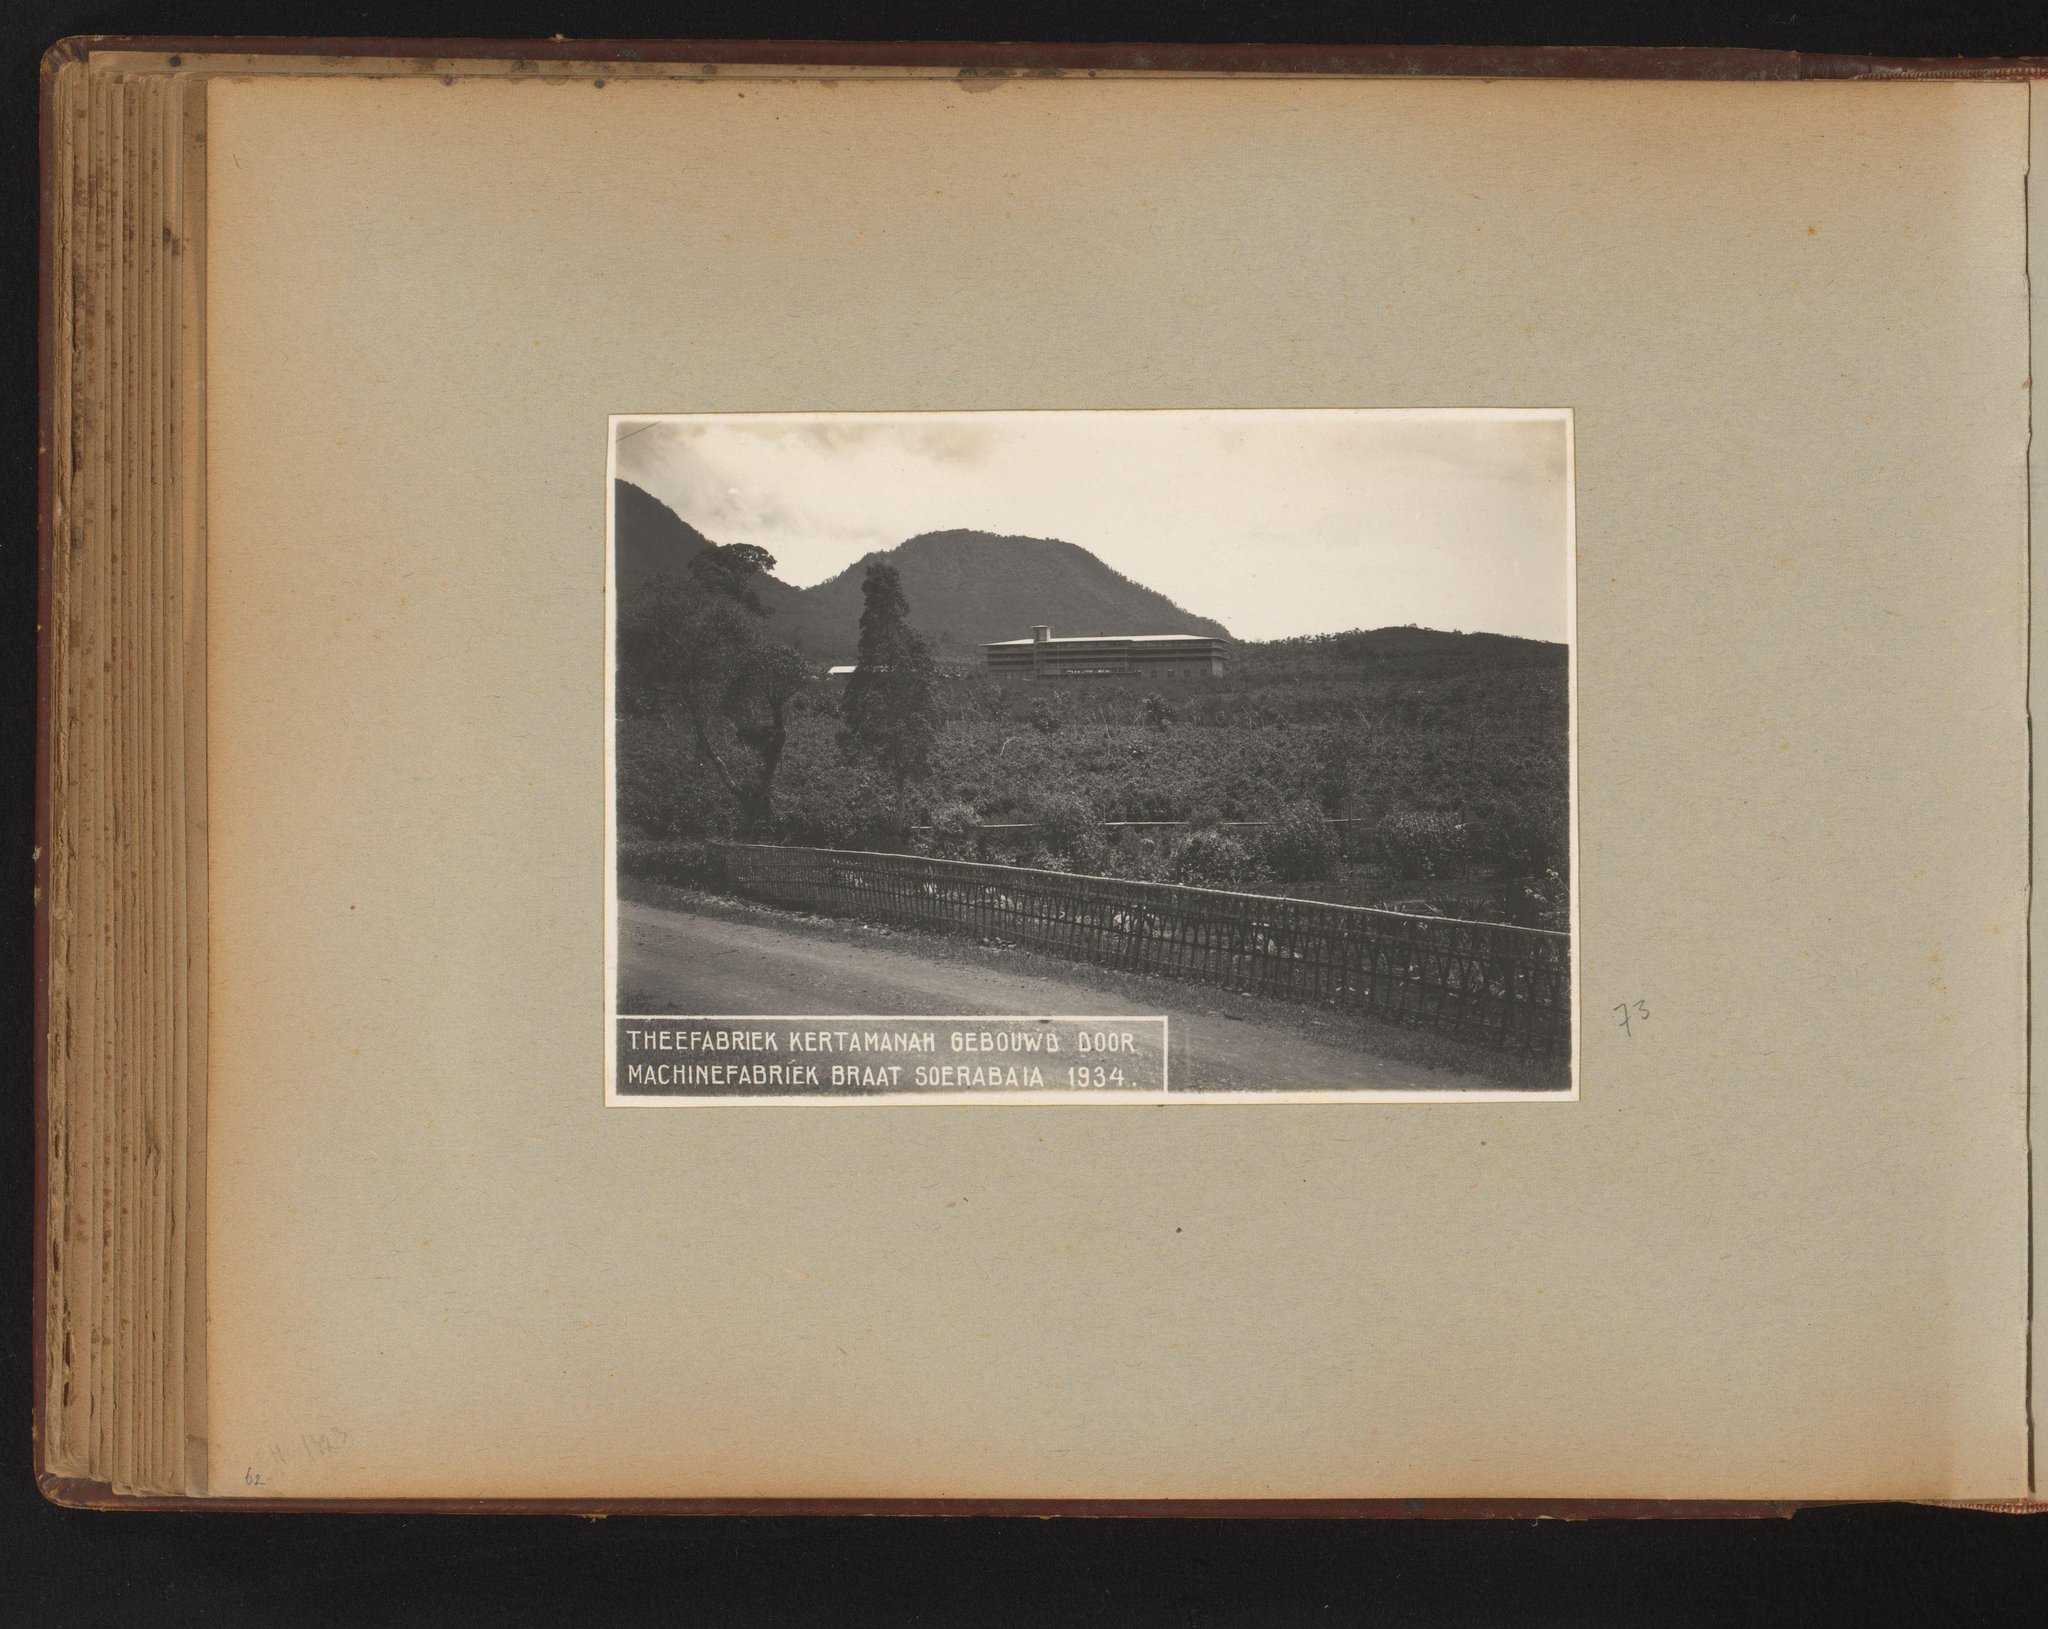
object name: photograph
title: Theefabriek Kertamanah gebouwd door Machinefabriek Braat Soerabaia 1934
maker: Anonymous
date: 1934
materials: cardboard, photographic support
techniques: gelatin silver print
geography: bandung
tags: factory-building, java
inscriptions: date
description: Albumblad met een foto van de ligging van theefabriek Kertamanah in het landschap ten zuiden van Bandoeng. Onderdeel van een fotoalbum met foto's van machines en constructies van de N.V. Machinefabriek Braat te Soerabaja, Soekaboemi en Tegal uit de periode 1931-1937.